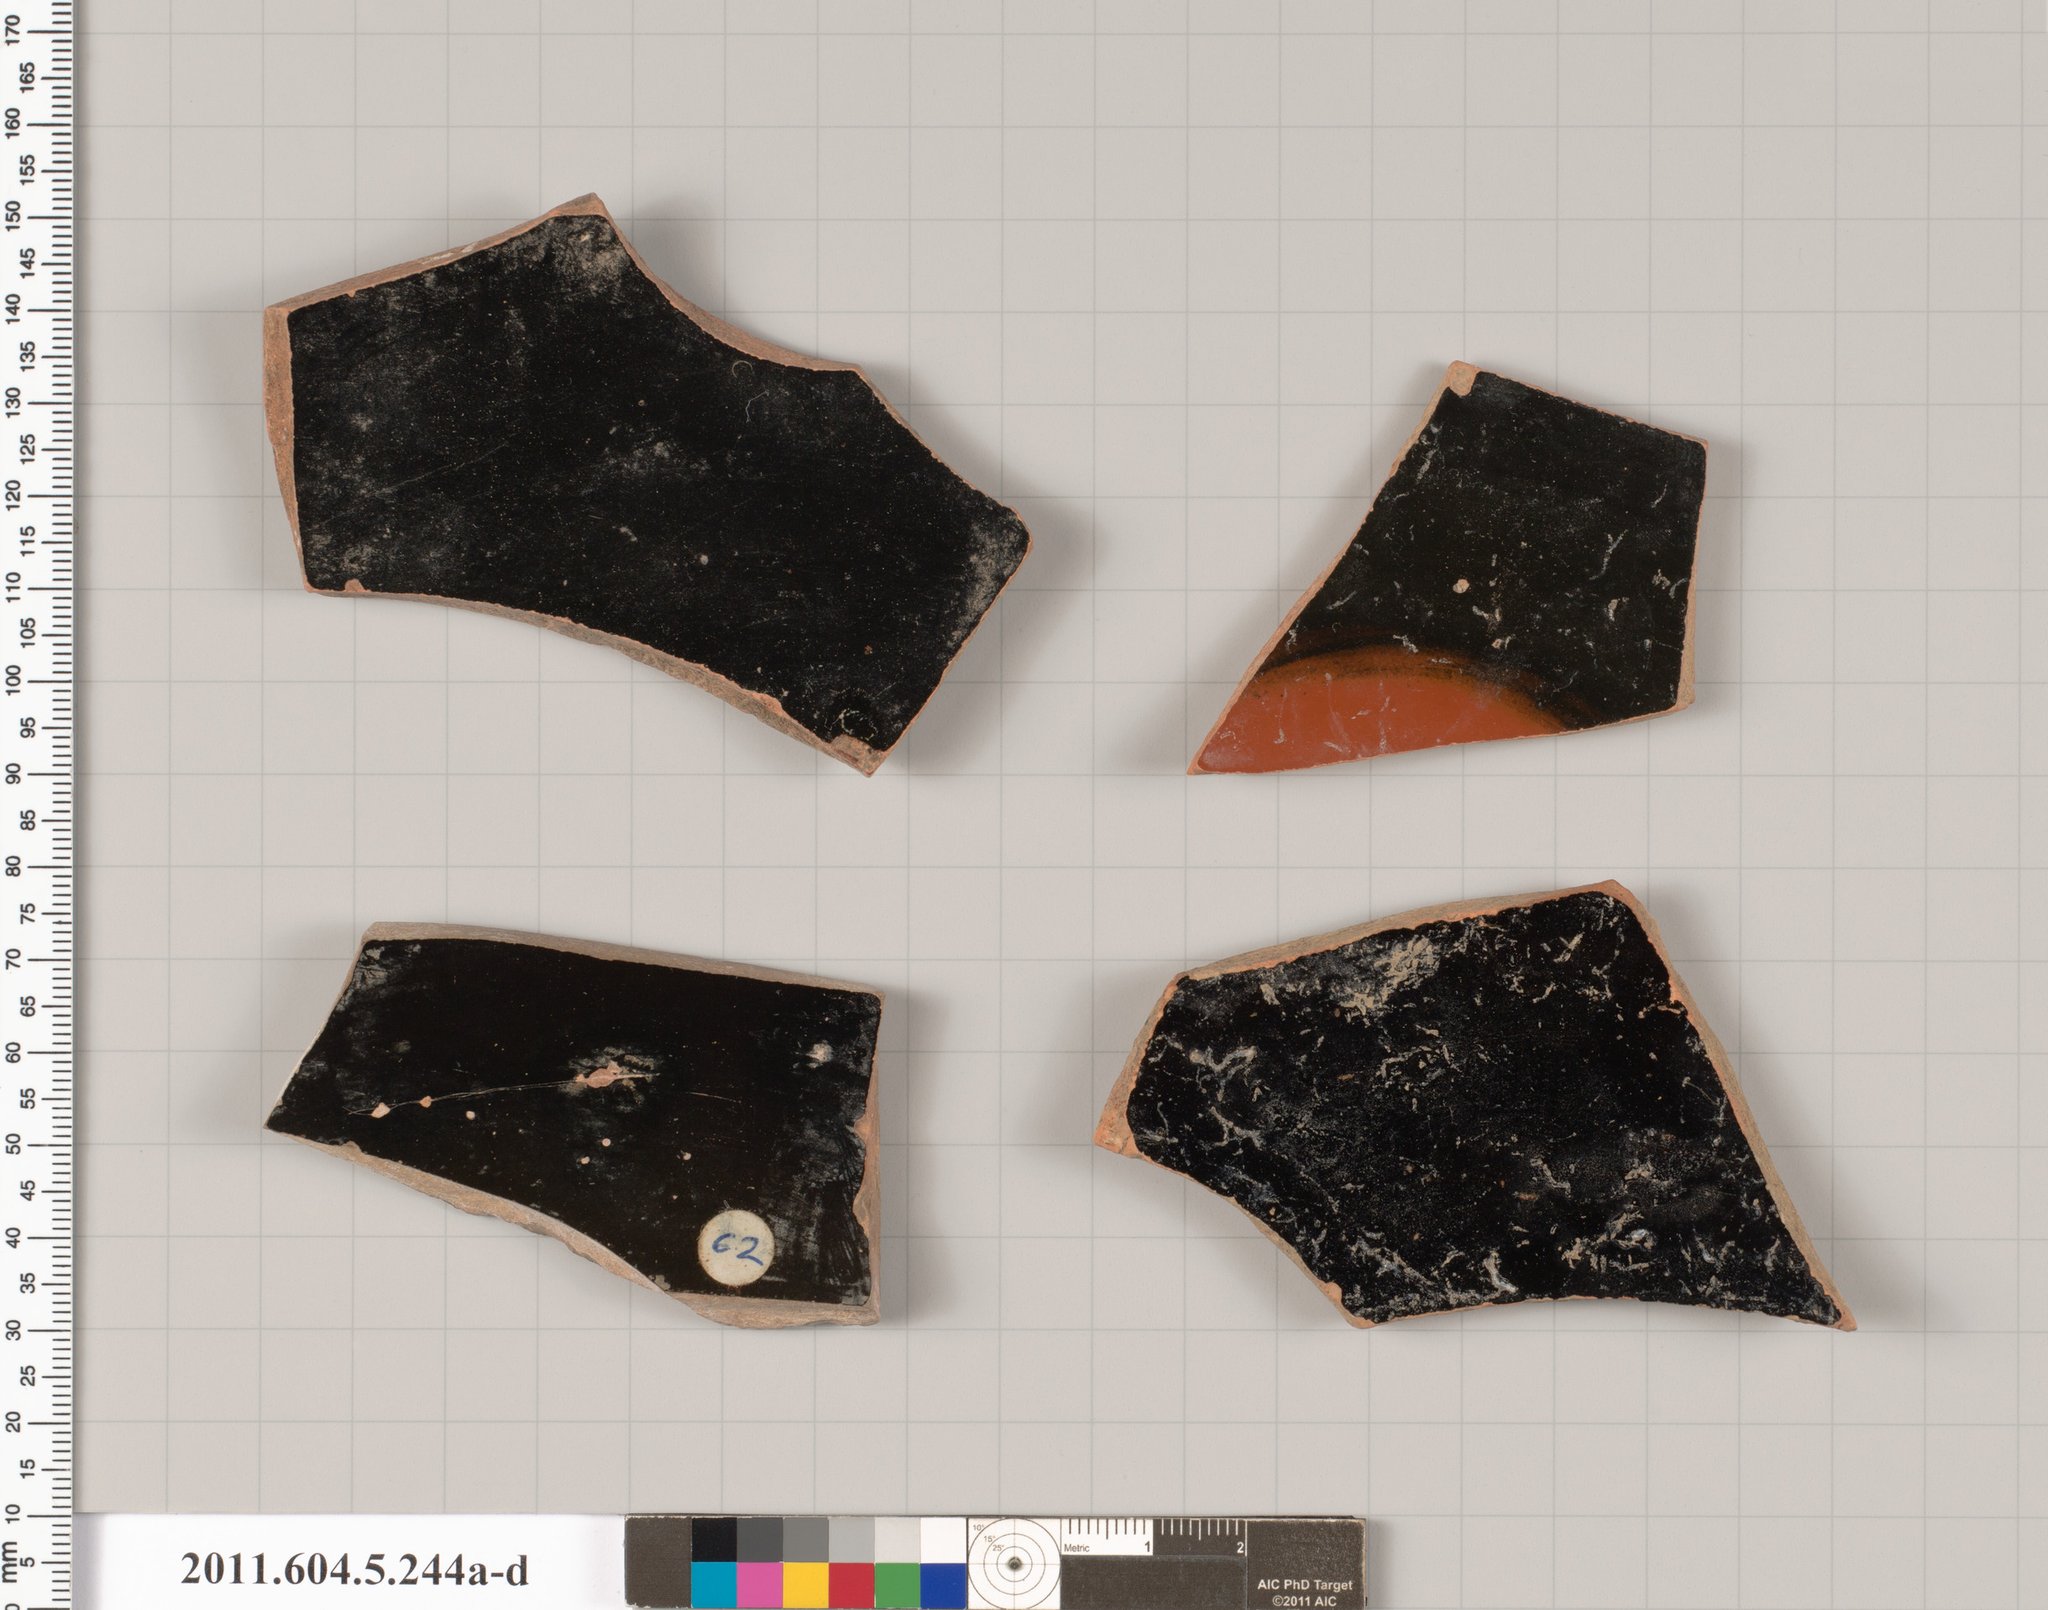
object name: kylix fragment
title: Terracotta fragments of kylikes (drinking cups)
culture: greek, attic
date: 600-401 BCE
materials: terracotta